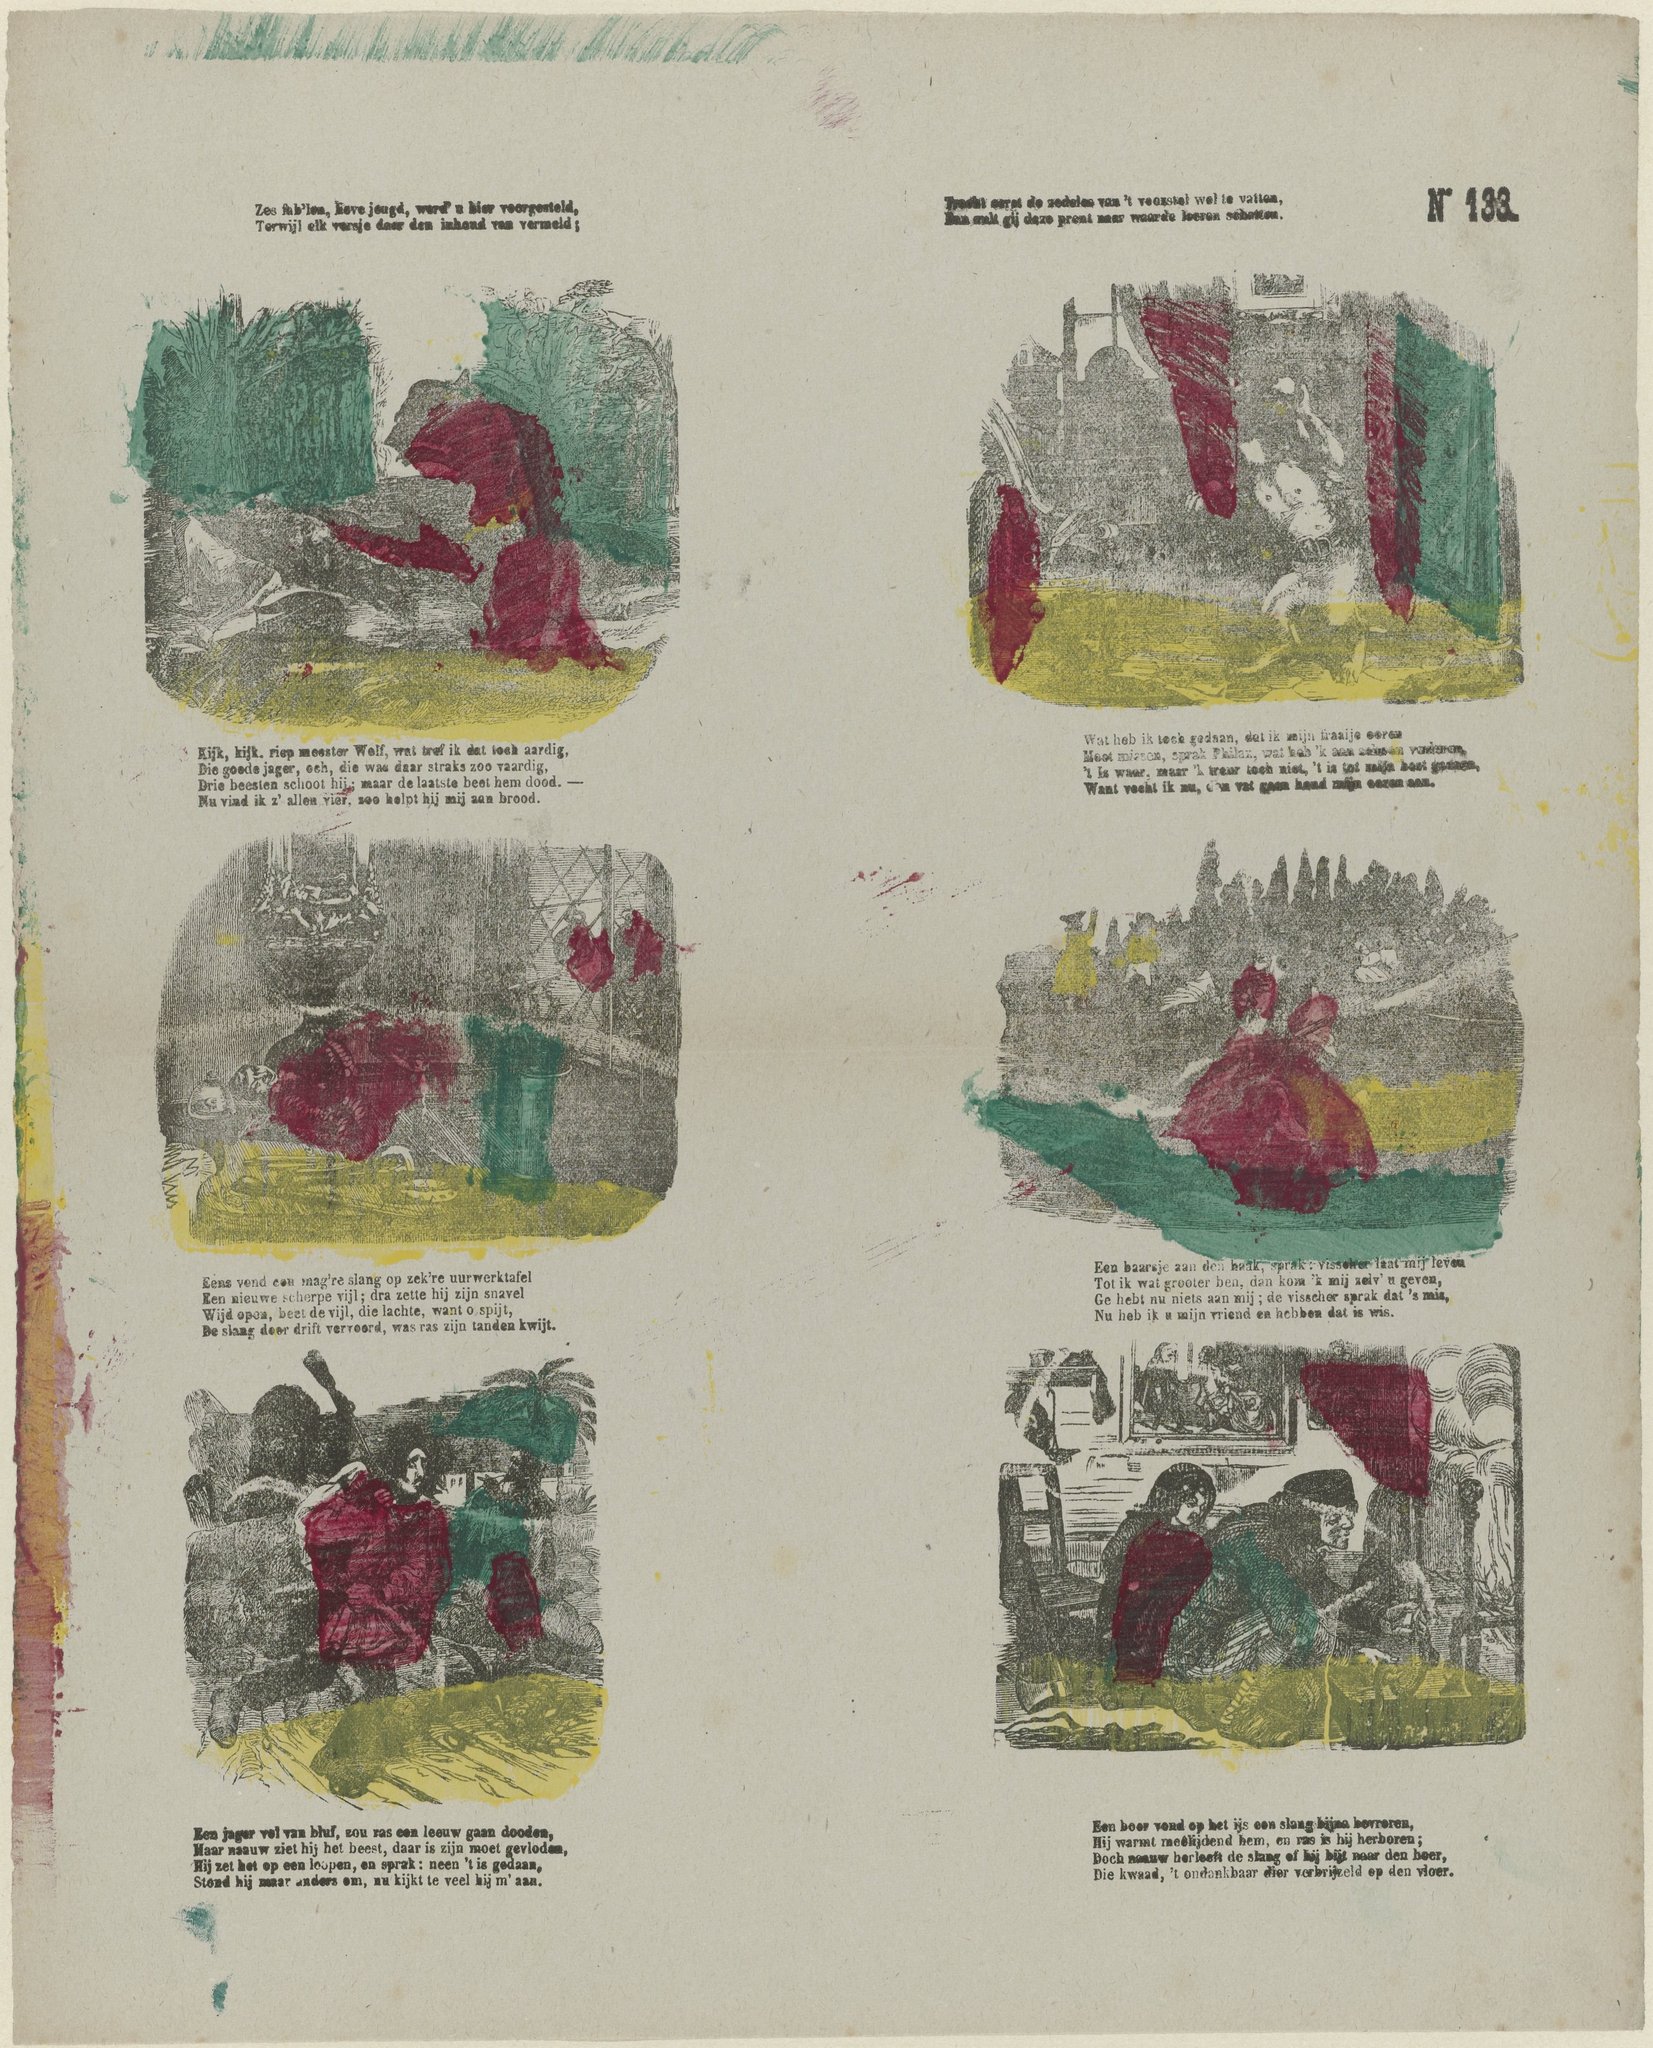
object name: popular print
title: Zes fab'len, lieve jeugd, word' u hier voorgesteld, / Terwijl elk versje daar den inhoud van vermeld; / Tracht eerst de zedeles van 't voorstel wel te vatten, / Dan zult gij deze prent naar waarde leeren schatten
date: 1827-1894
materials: paper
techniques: colour, letterpress printing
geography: schaarbeek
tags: animals acting as human beings, characters (human types), fables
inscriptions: collector's mark: Lugt 2760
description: Blad met 6 voorstellingen van verschillende aard, waaronder voorstellingen van fabels. Onder elke afbeelding een vierregelig vers. Genummerd rechtsboven: No 133.